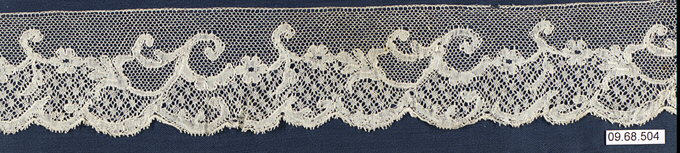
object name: fragment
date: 1801-1900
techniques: lace